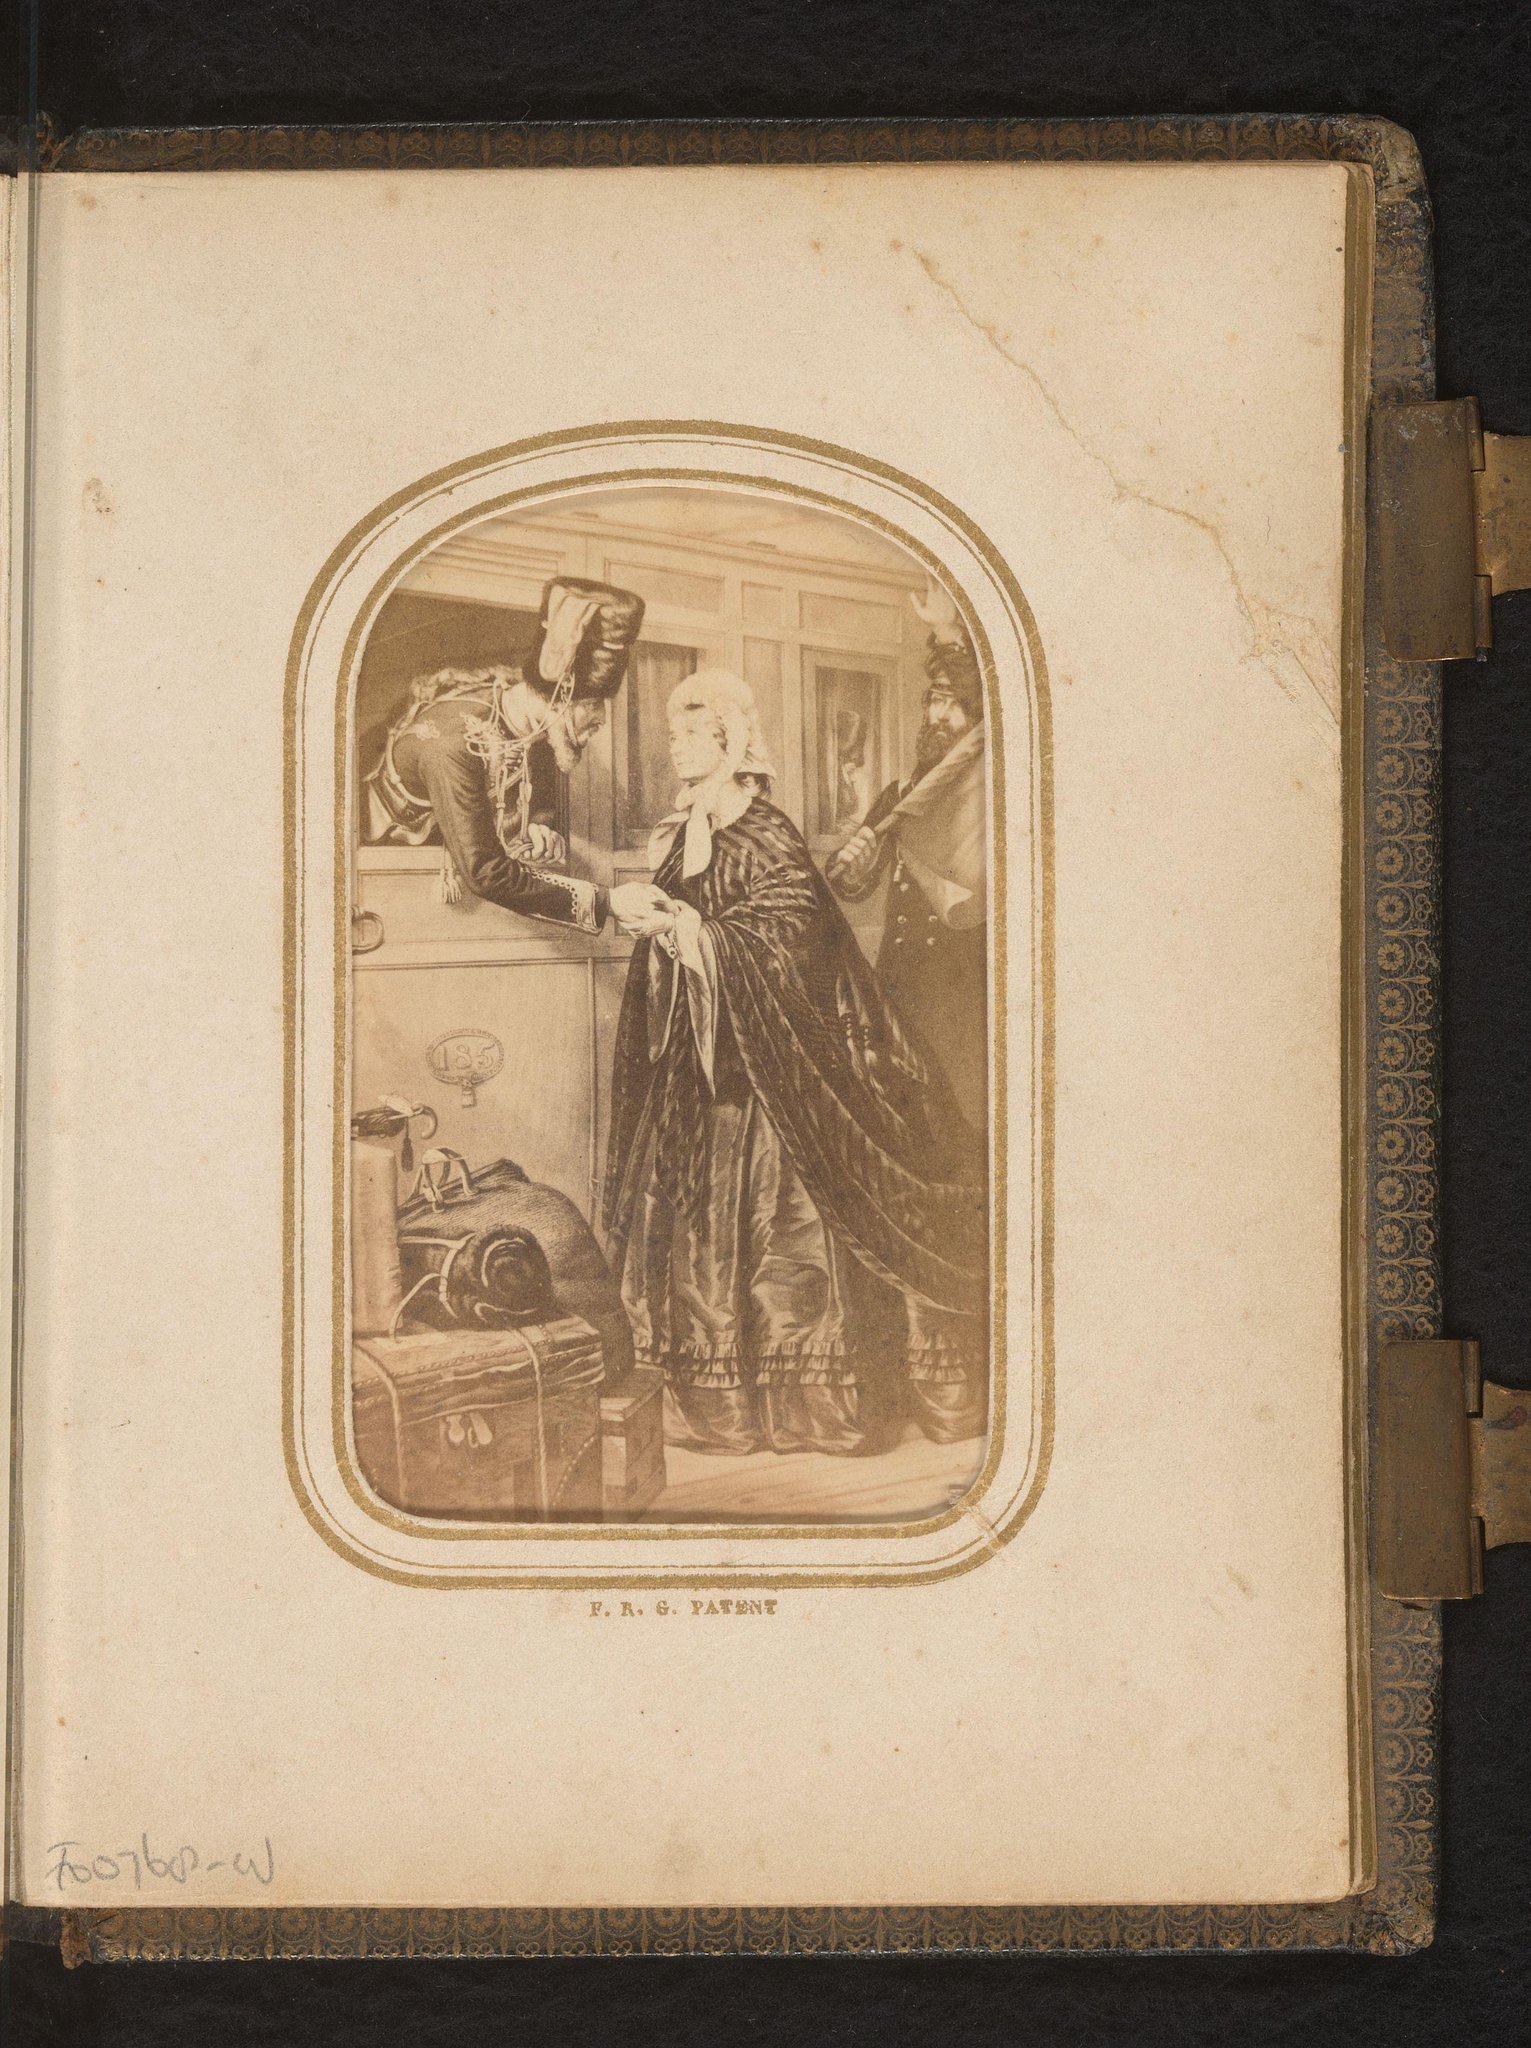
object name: album leaf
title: Fotoreproductie van een schilderij van een vrouw en een soldaat die afscheid nemen bij een trein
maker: Anonymous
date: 1860-1890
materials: cardboard, photographic support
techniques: albumen print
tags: adult woman, railway, train, the soldier; the soldier's life, painting, drawing and the graphic arts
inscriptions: annotation: ‘Ordered on foreign service’